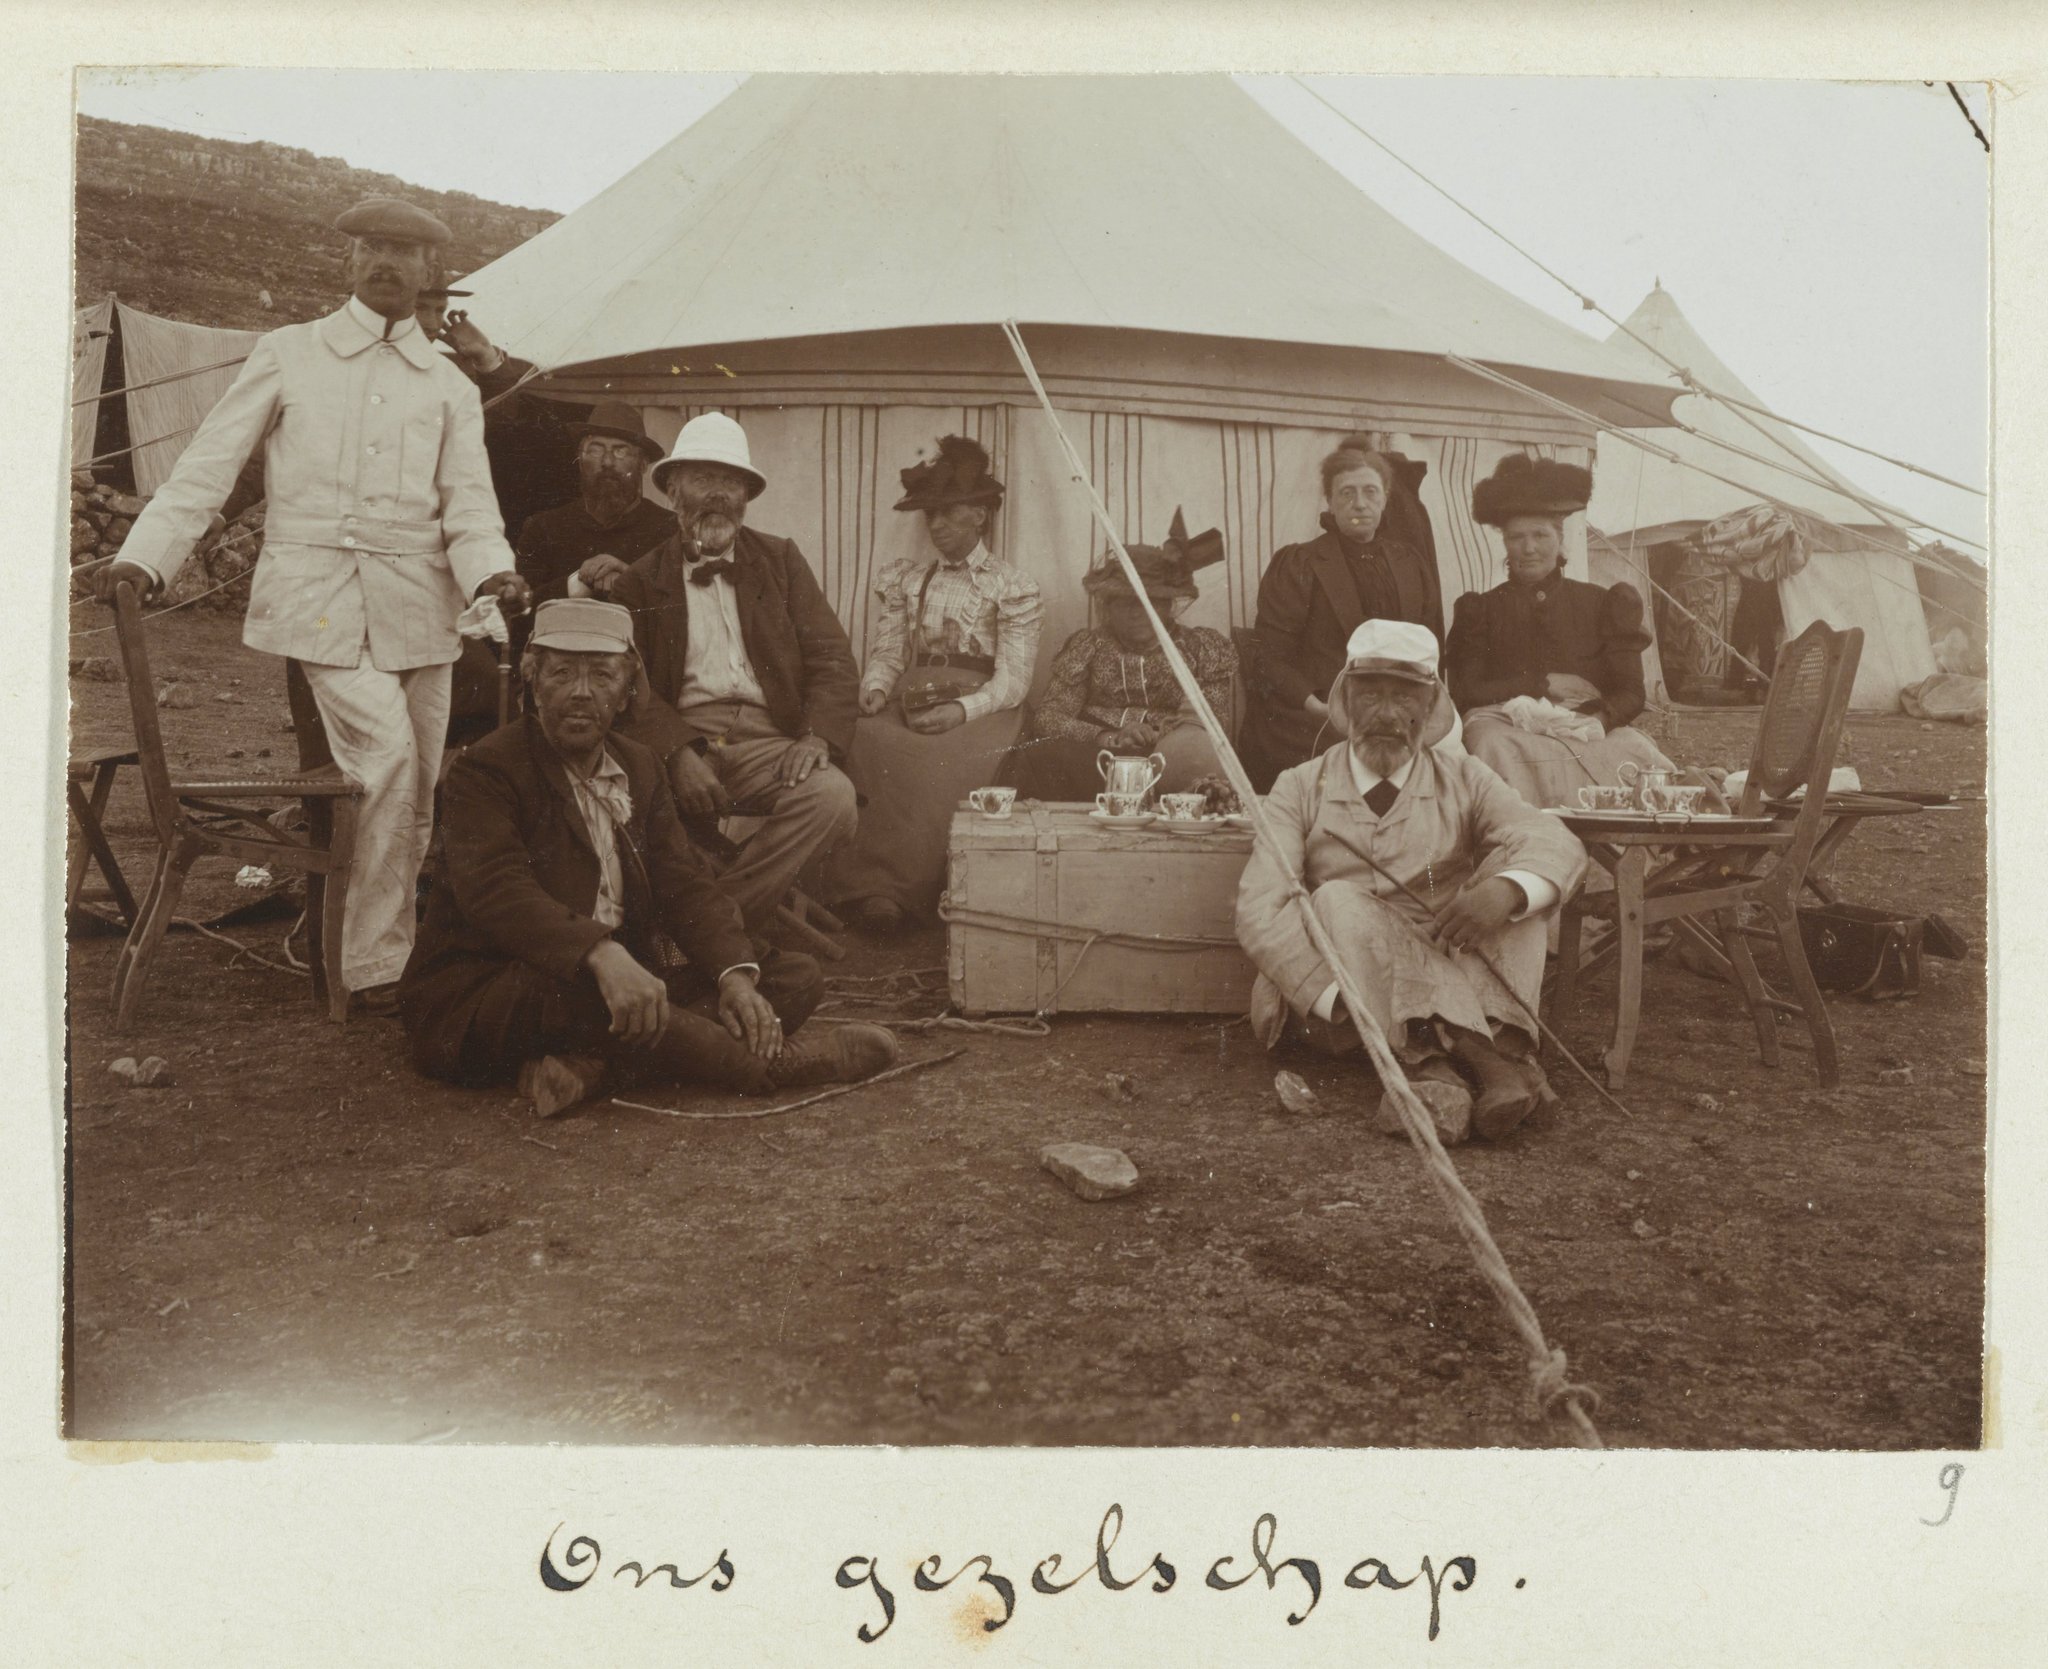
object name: photograph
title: Ons gezelschap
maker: johannes lodewijk heldring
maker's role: fotograaf, predikant, schrijver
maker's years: 1852-1923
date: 1898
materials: paper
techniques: collodion silver print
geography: syria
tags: (traveller) resting in the open air